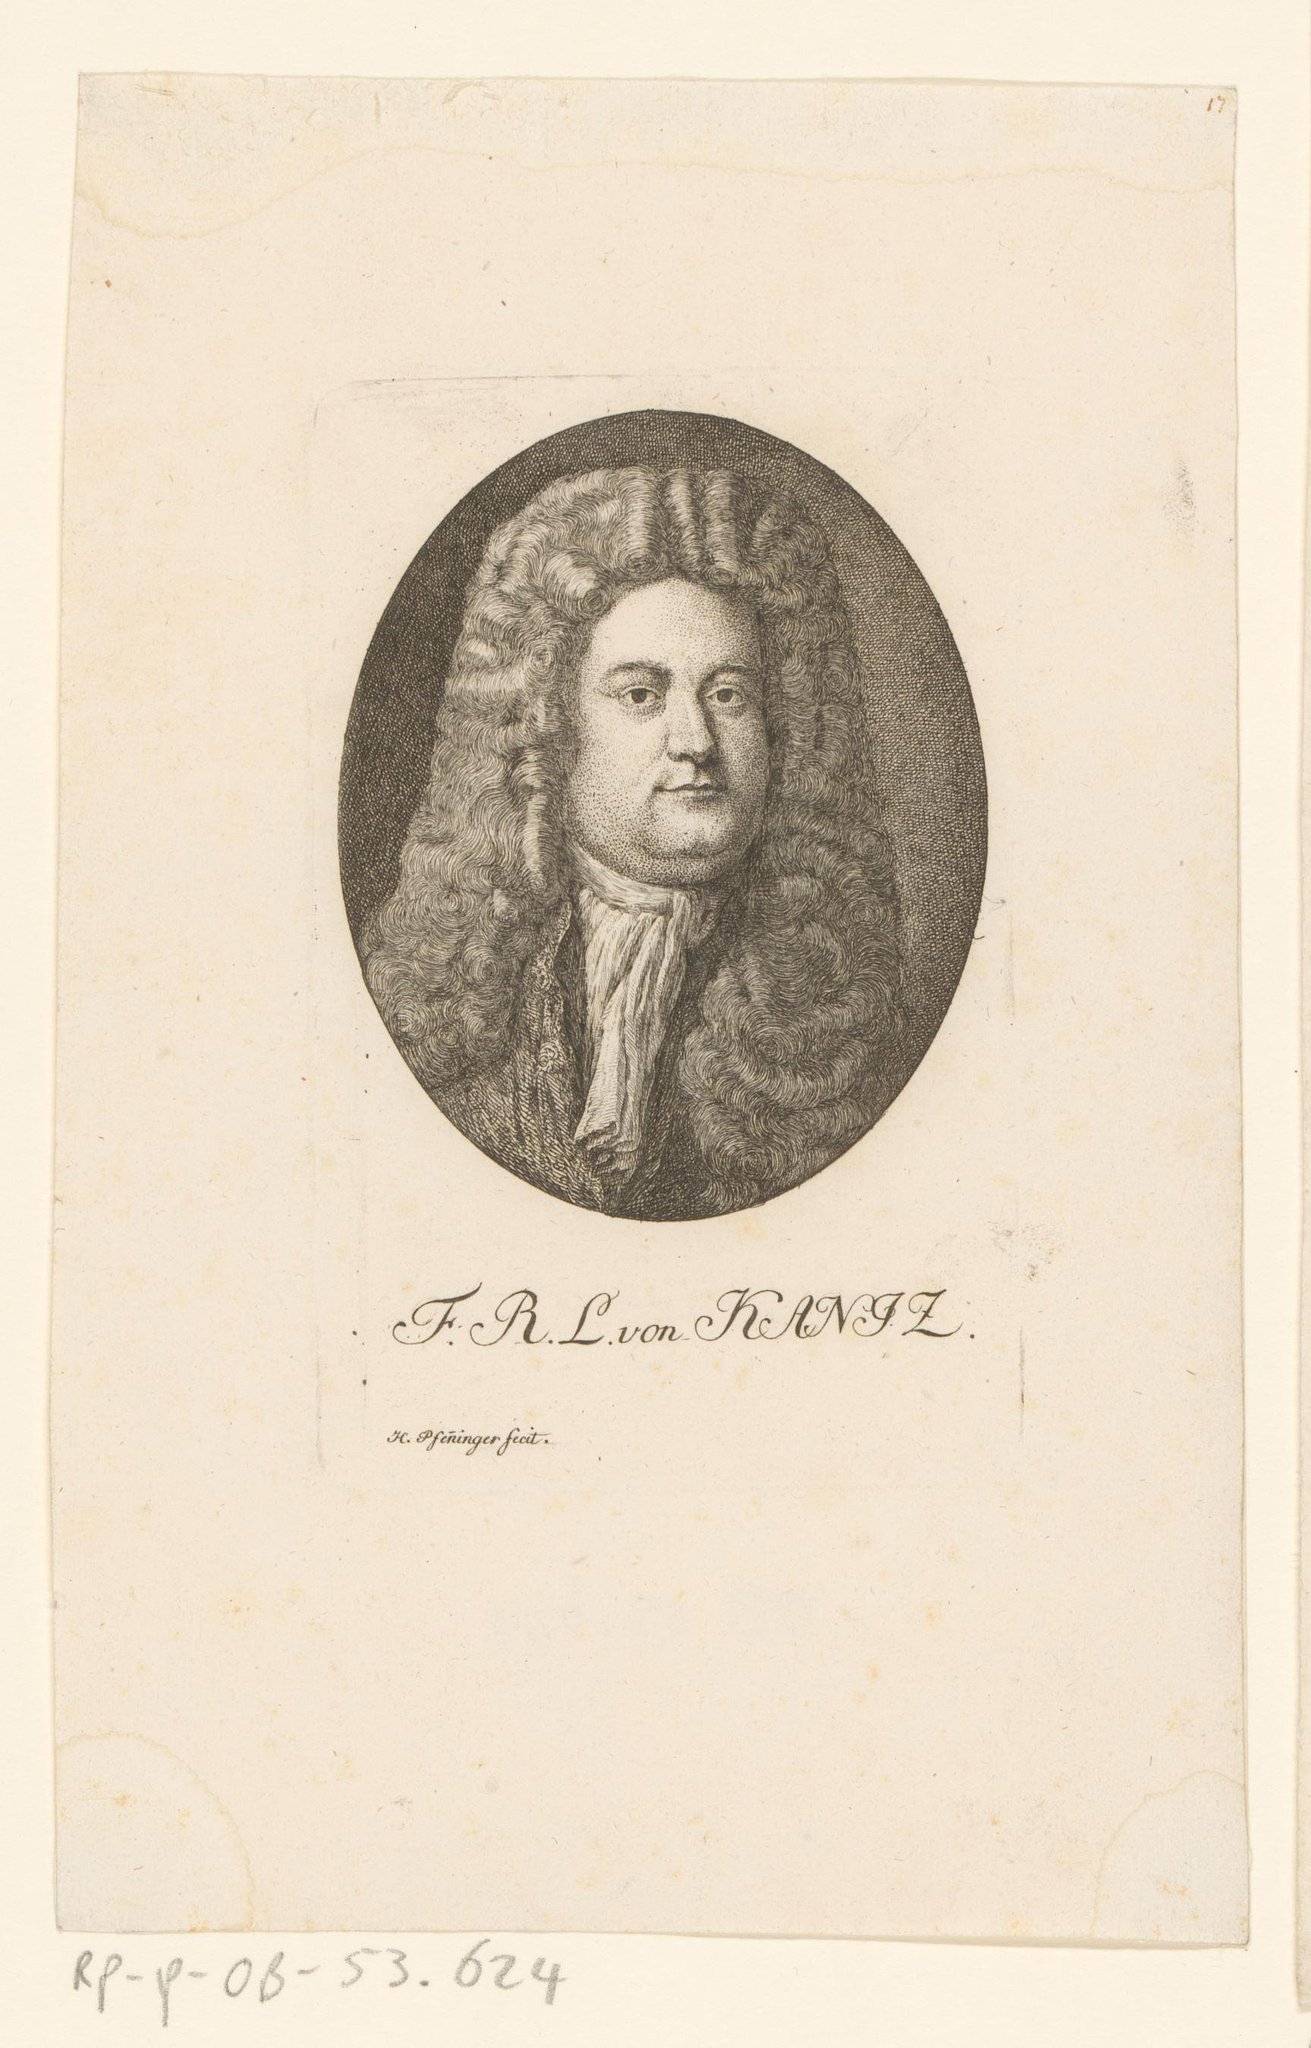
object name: print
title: Portret van F.R.L. von Kaniz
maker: heinrich pfenninger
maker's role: print maker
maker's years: 1749-1815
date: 1759-1815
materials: paper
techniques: etching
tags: historical persons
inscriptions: collector's mark: Lugt 2228